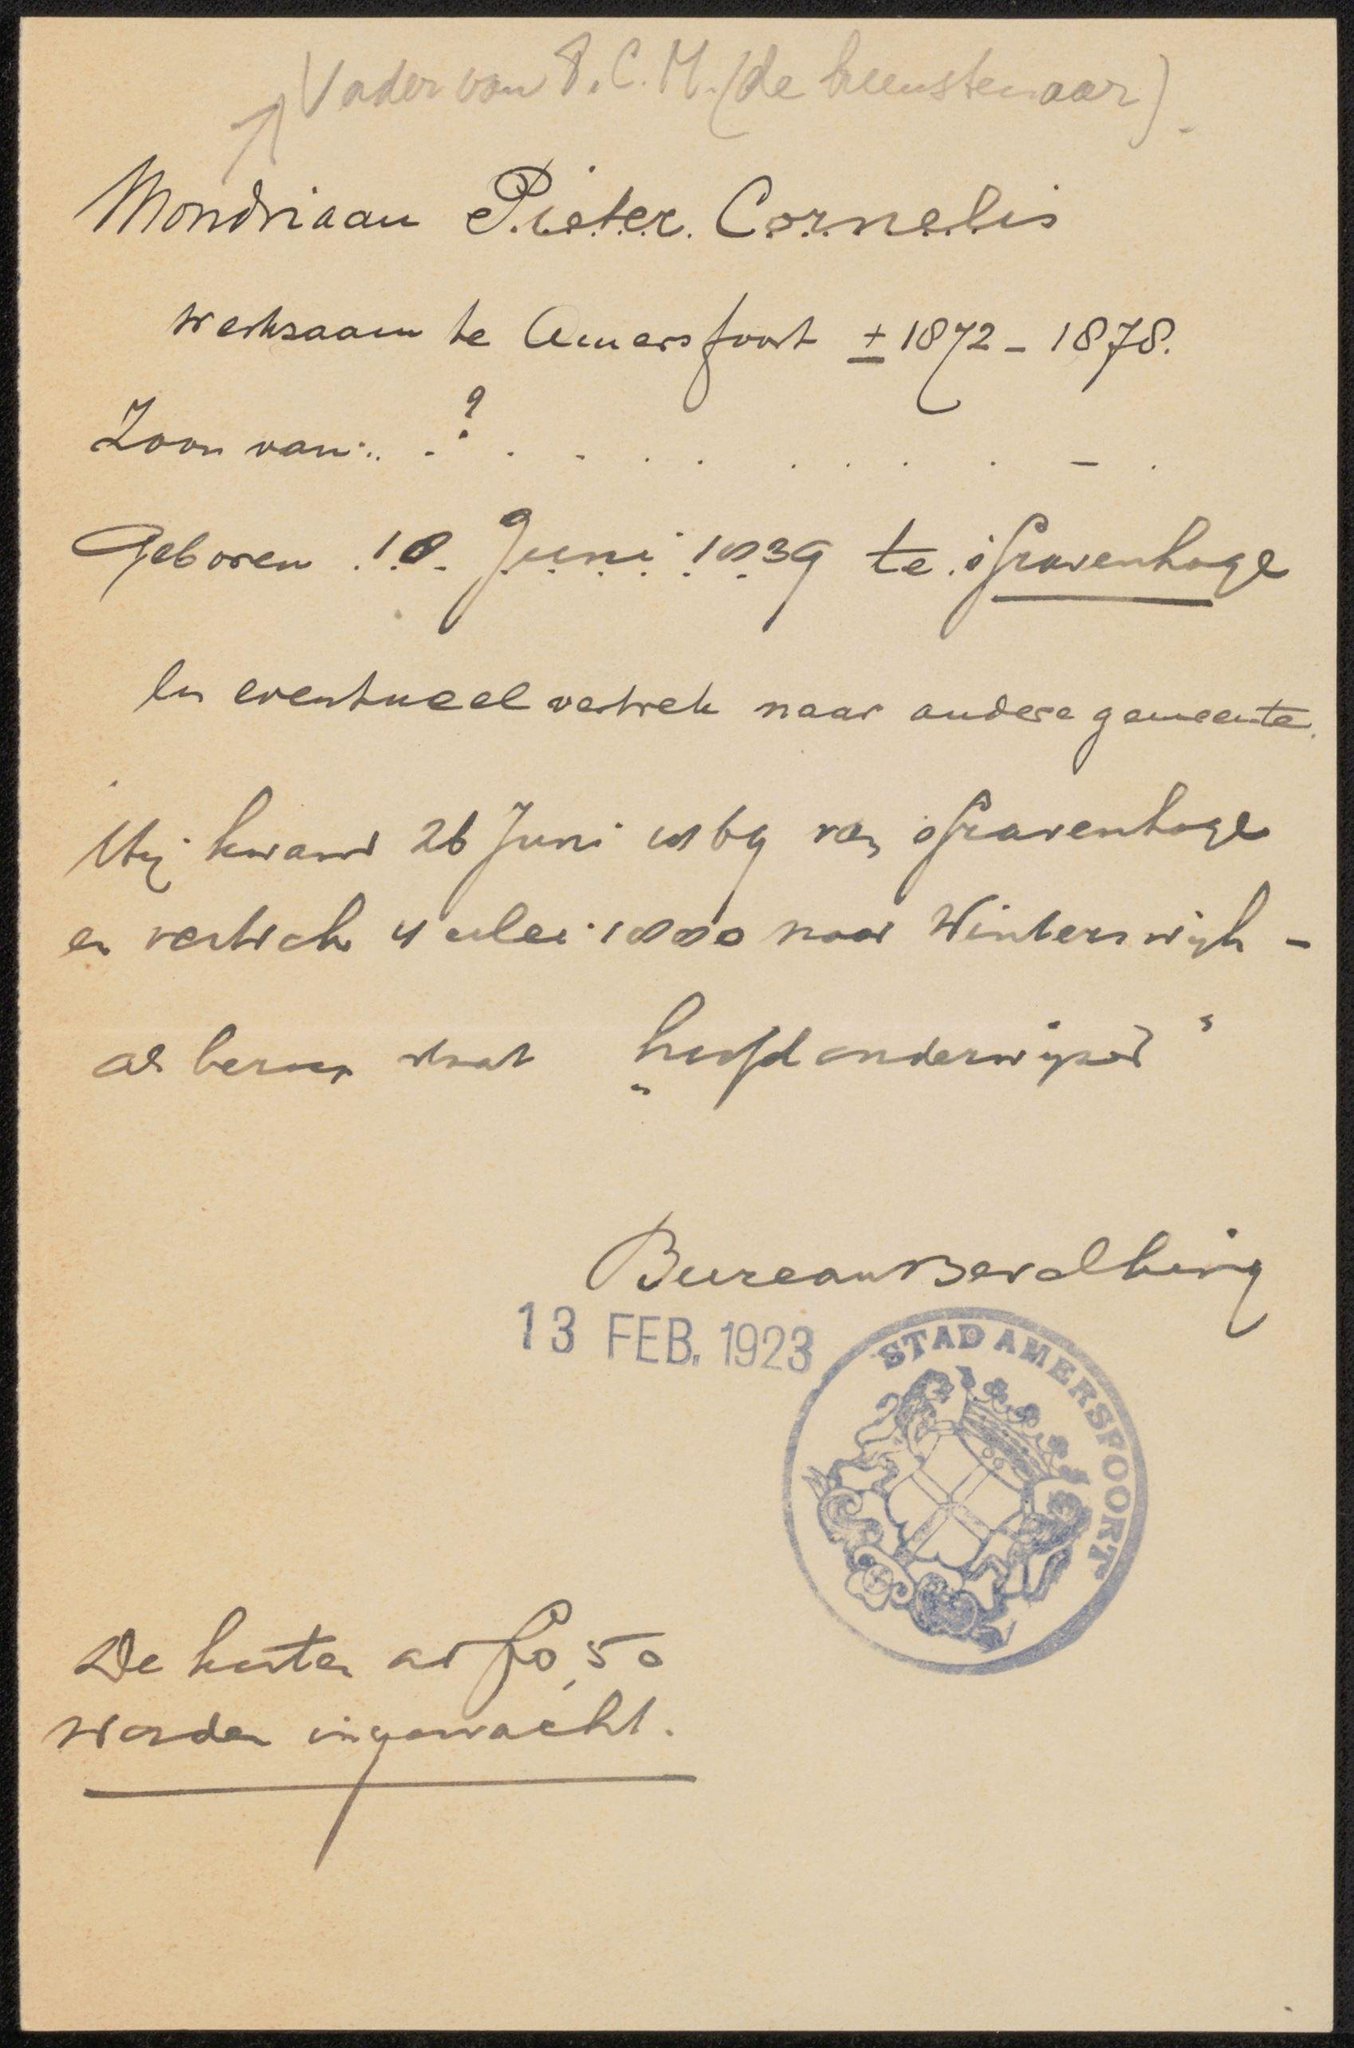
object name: letter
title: Brief aan anoniem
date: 1923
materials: ink, paper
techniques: pen, writing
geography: amersfoort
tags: the hague, arnhem, pieter cornelis mondriaan (sr.), money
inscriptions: name